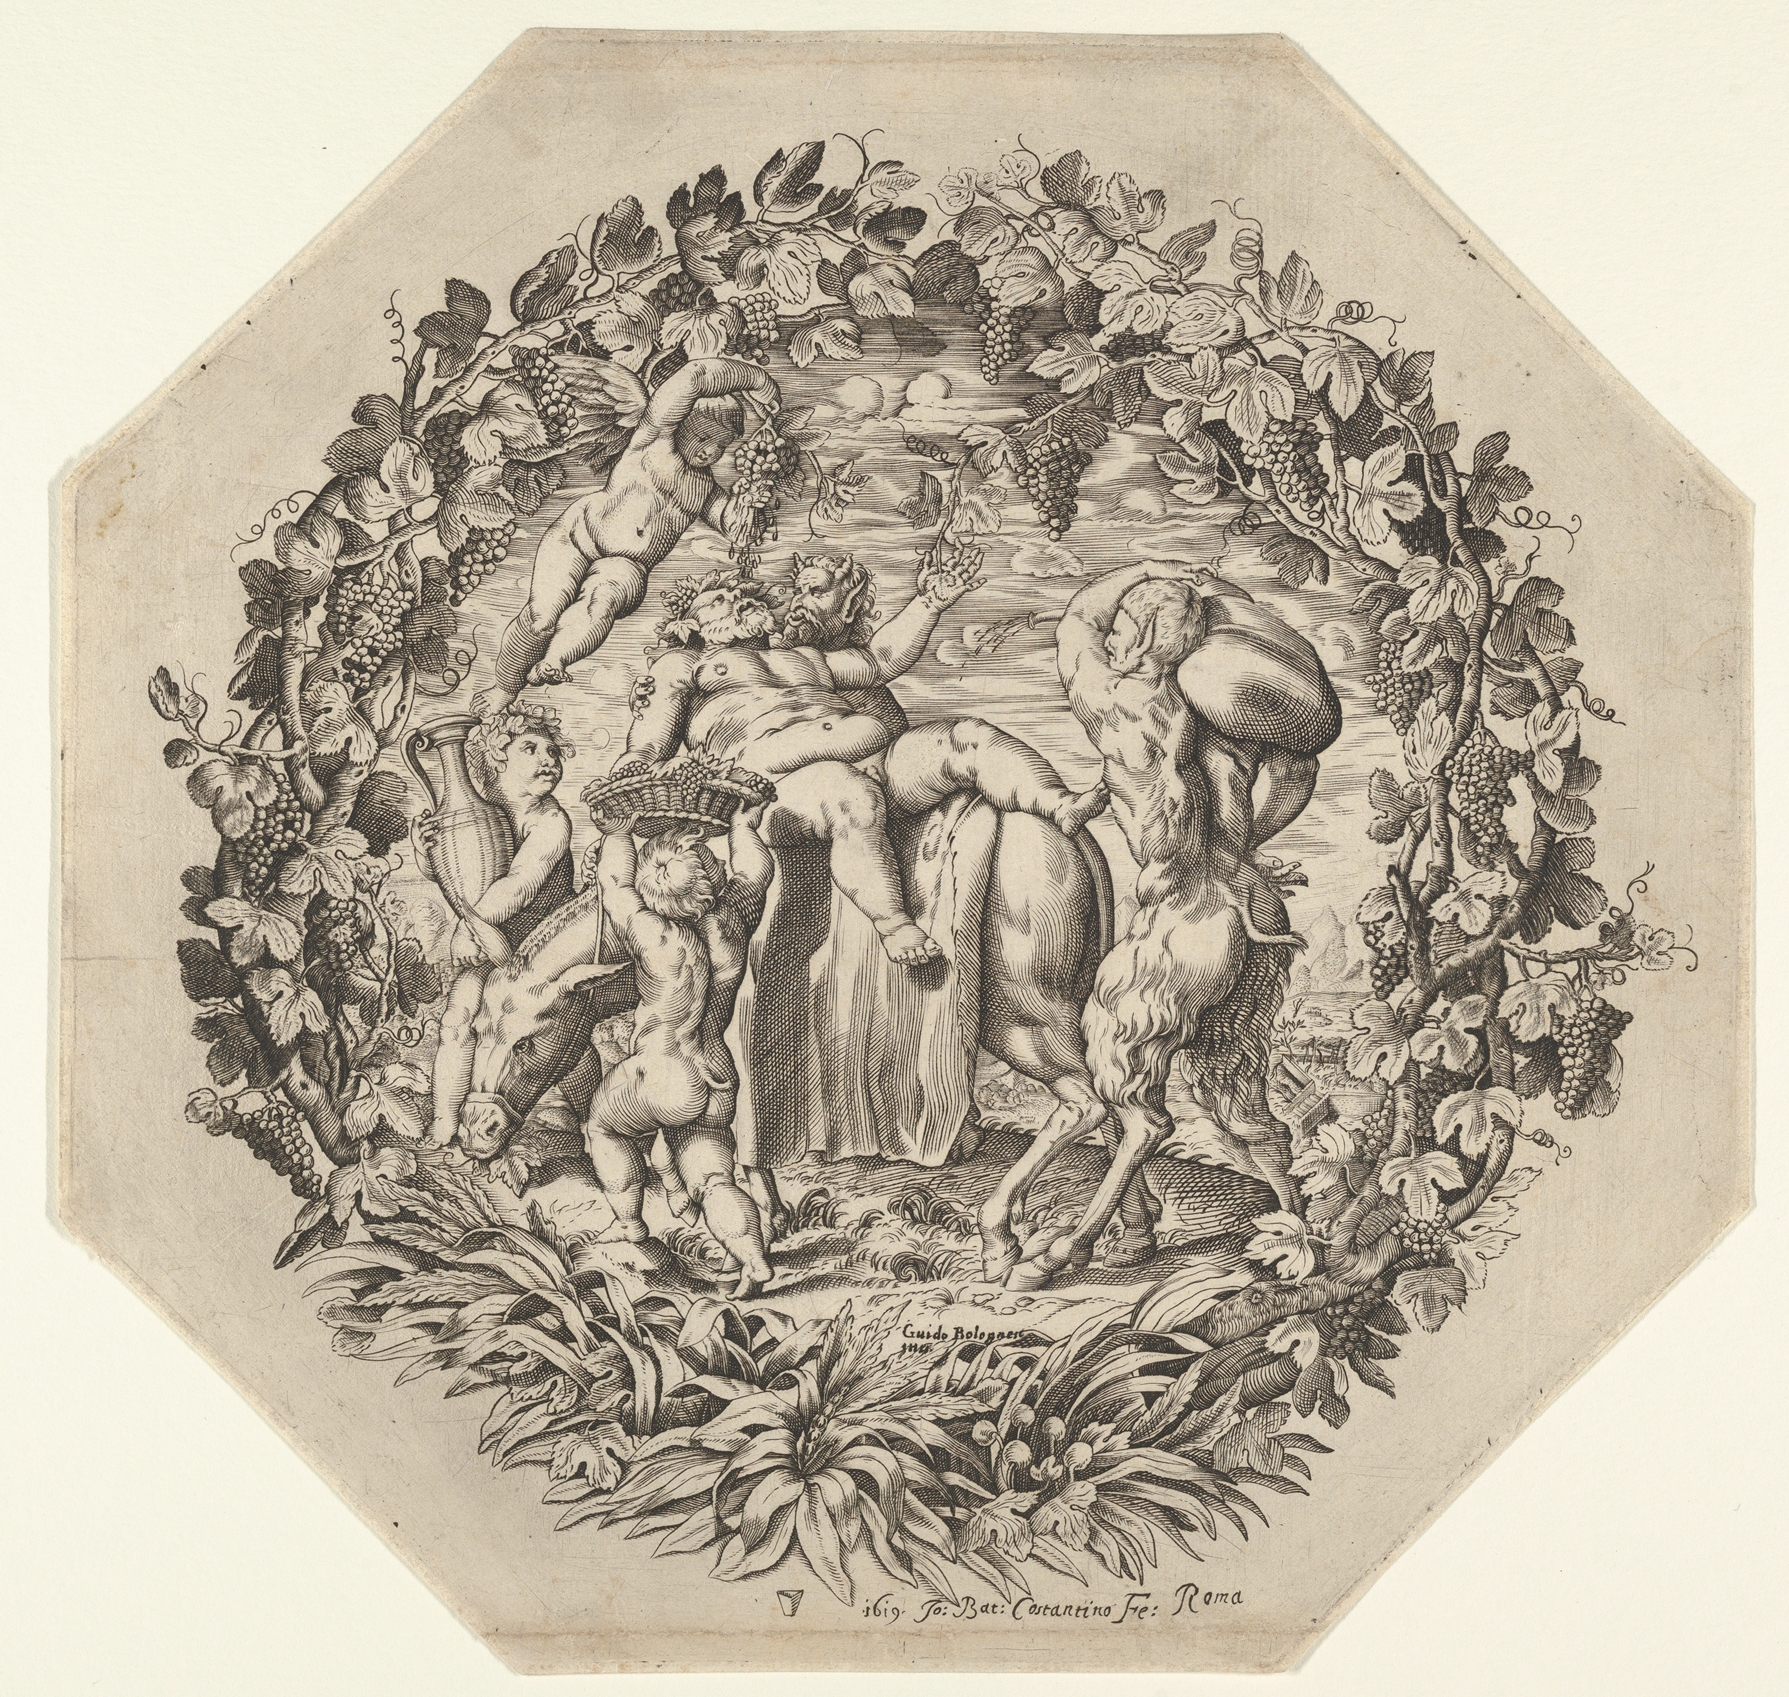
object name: print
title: A Bacchanal: a satyr holds Silenus as he lies on a donkey's back and picks a leaf from a garland, two putti carry an amphora and a basket with grapes at left, and a faun carries a sack at right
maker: giovanni battista costantini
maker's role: artist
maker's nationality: italian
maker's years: 1615-1628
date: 1619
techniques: engraving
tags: grapes,bacchus,horses